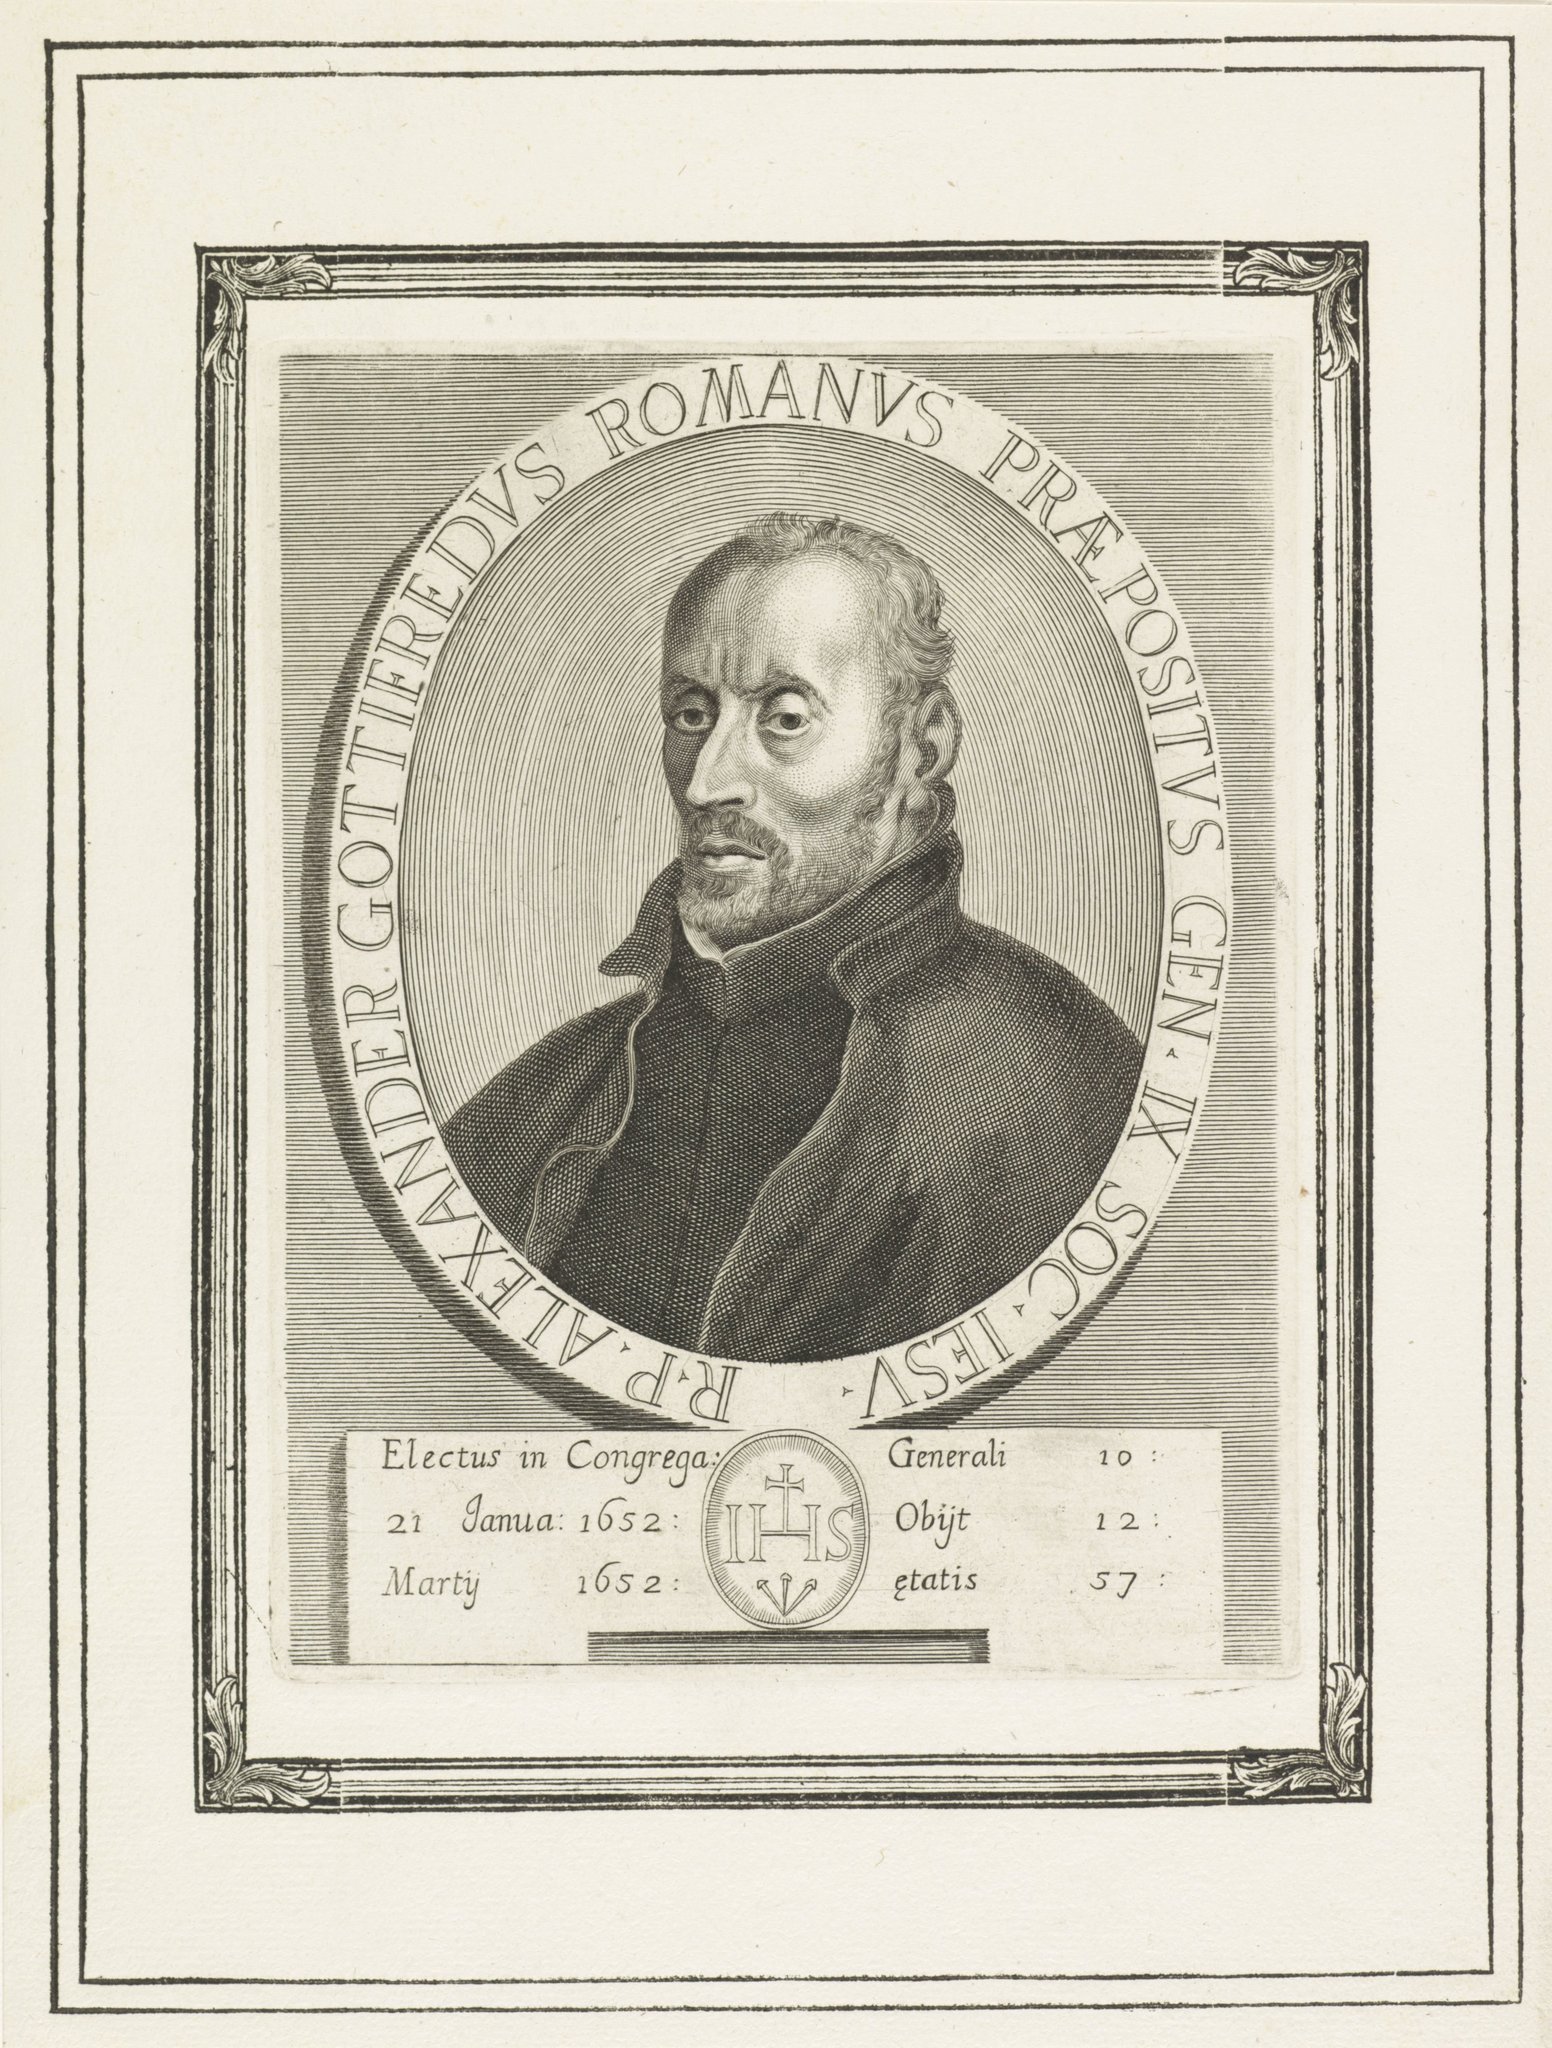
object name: book illustration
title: Portret van de Italiaanse priester Alessandro Gottifredi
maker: arnold van westerhout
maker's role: print maker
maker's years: 1651-1725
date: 1751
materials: paper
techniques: engraving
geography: italy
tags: priest, ihs ('iesus hominum salvator') ~ symbol of christ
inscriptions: title: ‘R.P. ALEXANDER GOTTIFREDUS ROMANUS PRAEPOSITUS GENERALIS IX. SOC. IESU’, collector's mark: Lugt 2228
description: Prent gebruikt in: Galeotti, Niccolò. Imagines praepositorum generalium Societatis Jesu, delineatae, et aereis formis expressae ab Arnoldo Van Westherhout, addita perbrevi uniuscujusque vitae descriptione. Rome: Monaldini, 1751.